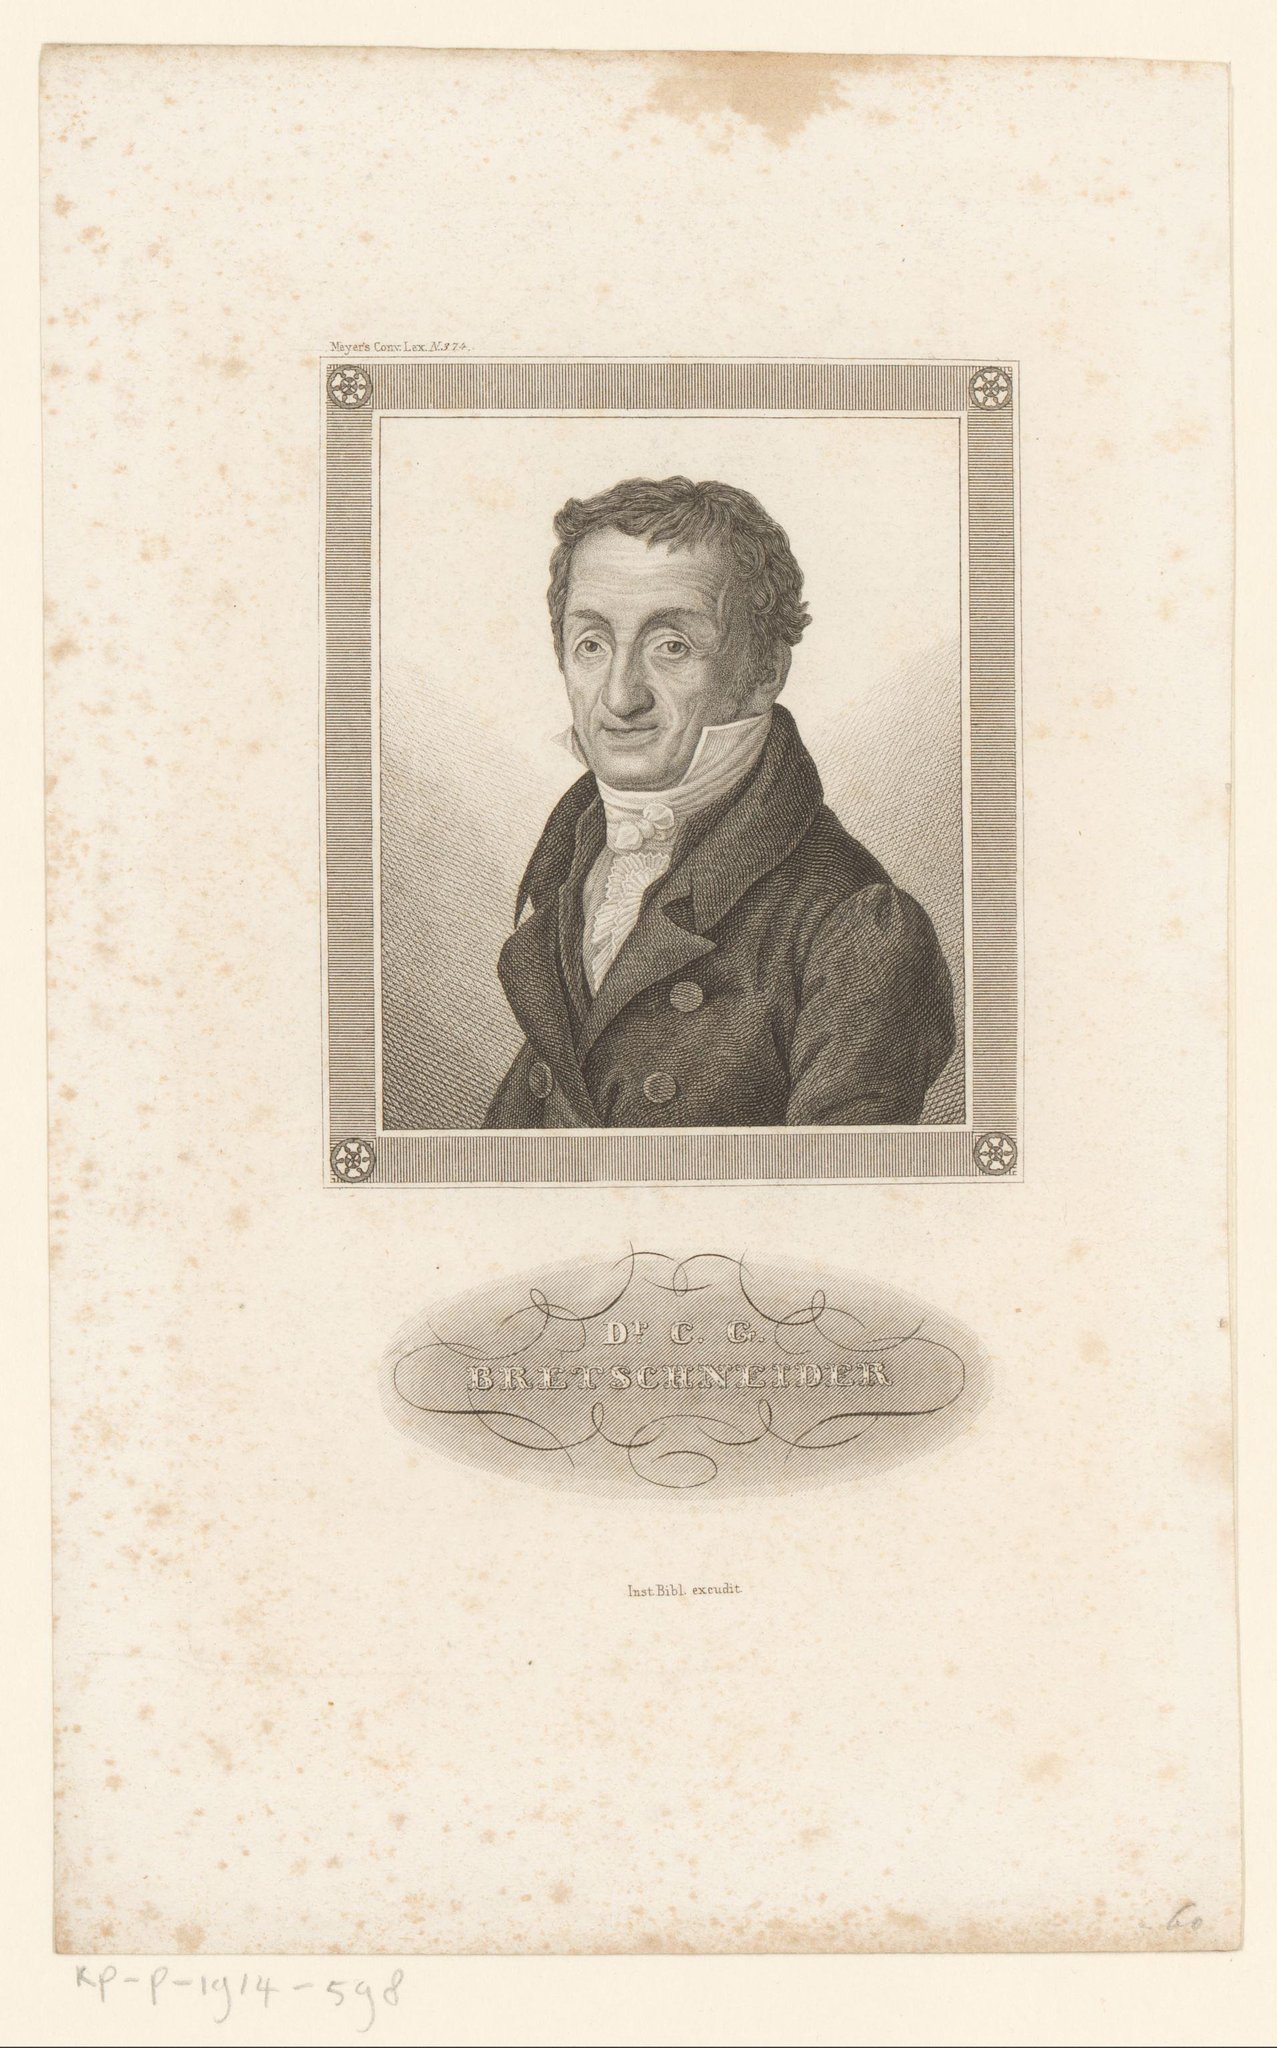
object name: book illustration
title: Portret van Karl Gottlieb Bretschneider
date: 1840-1855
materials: paper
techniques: etching, engraving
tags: zwickau, historical persons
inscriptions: collector's mark: Lugt 2228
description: Prent afkomstig uit: Conversations-Lexikon für die gebildeten Stände, voor het eerst uitgegeven tussen 1840-1855.